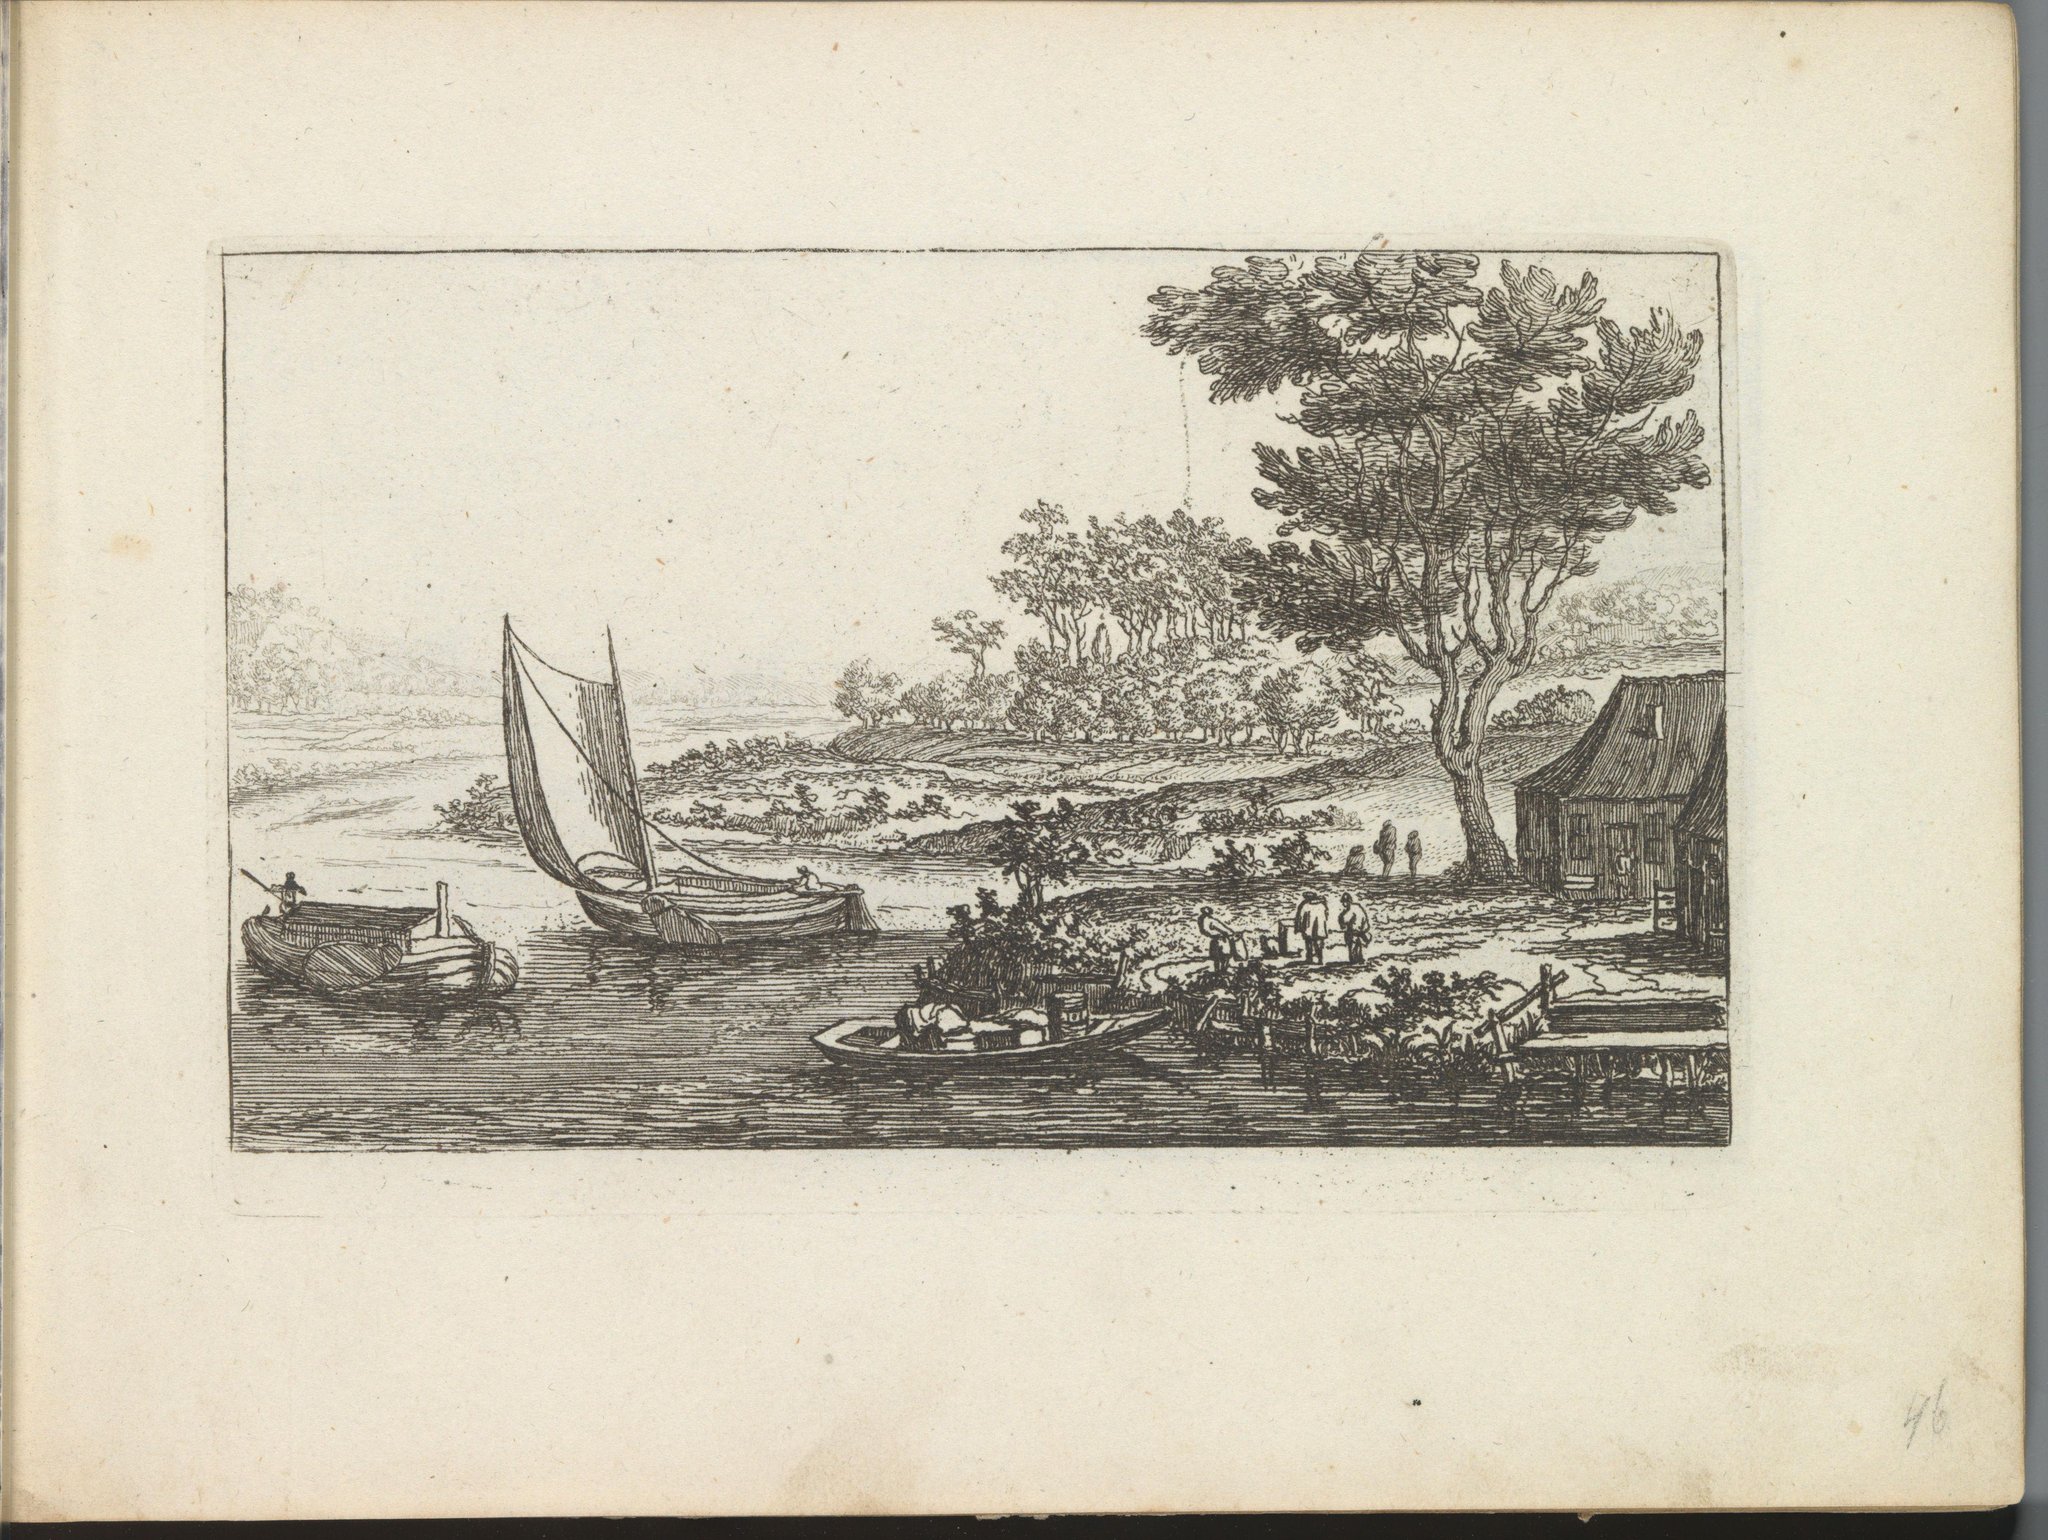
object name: print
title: Spiegel der natuur en school der teekenkunde (...)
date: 1662-1683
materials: paper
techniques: etching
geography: amsterdam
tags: landscapes, river